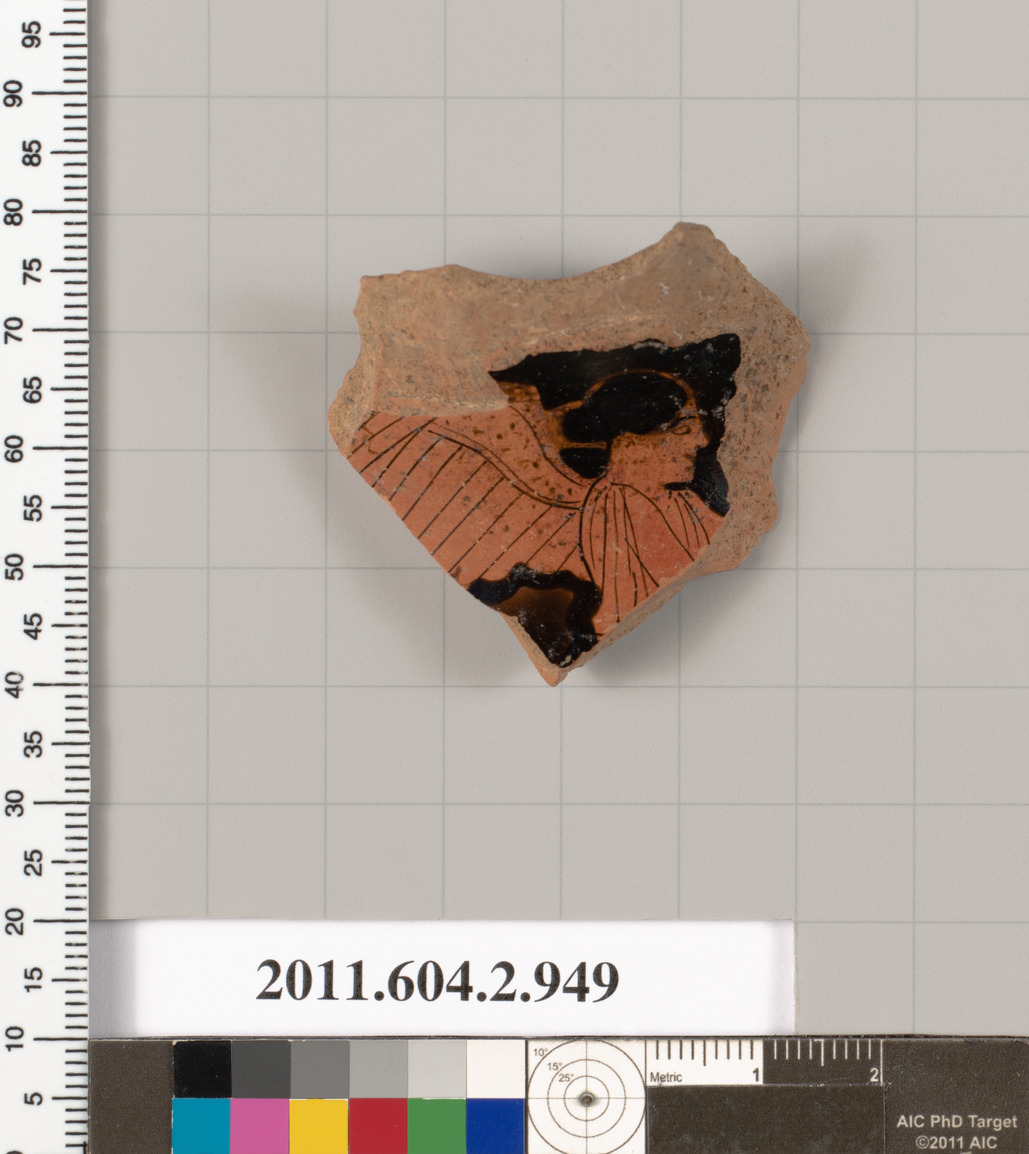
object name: oinochoe fragment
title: Terracotta fragment of an oinochoe (jug)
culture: greek, attic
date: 467-435 BCE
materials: terracotta